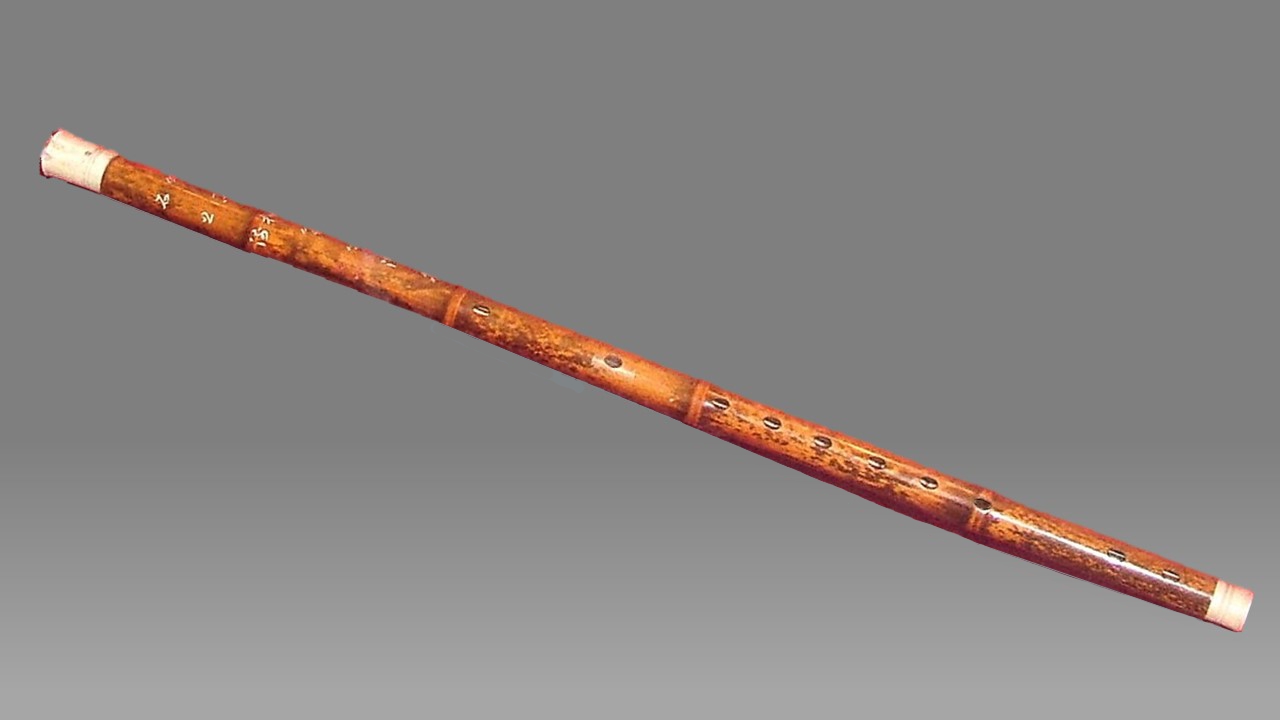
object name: dizi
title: Dizi (笛子 )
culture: chinese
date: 1867-1900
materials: bamboo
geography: china